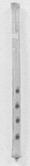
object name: pito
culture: colombian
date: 1801-1900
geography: colombia